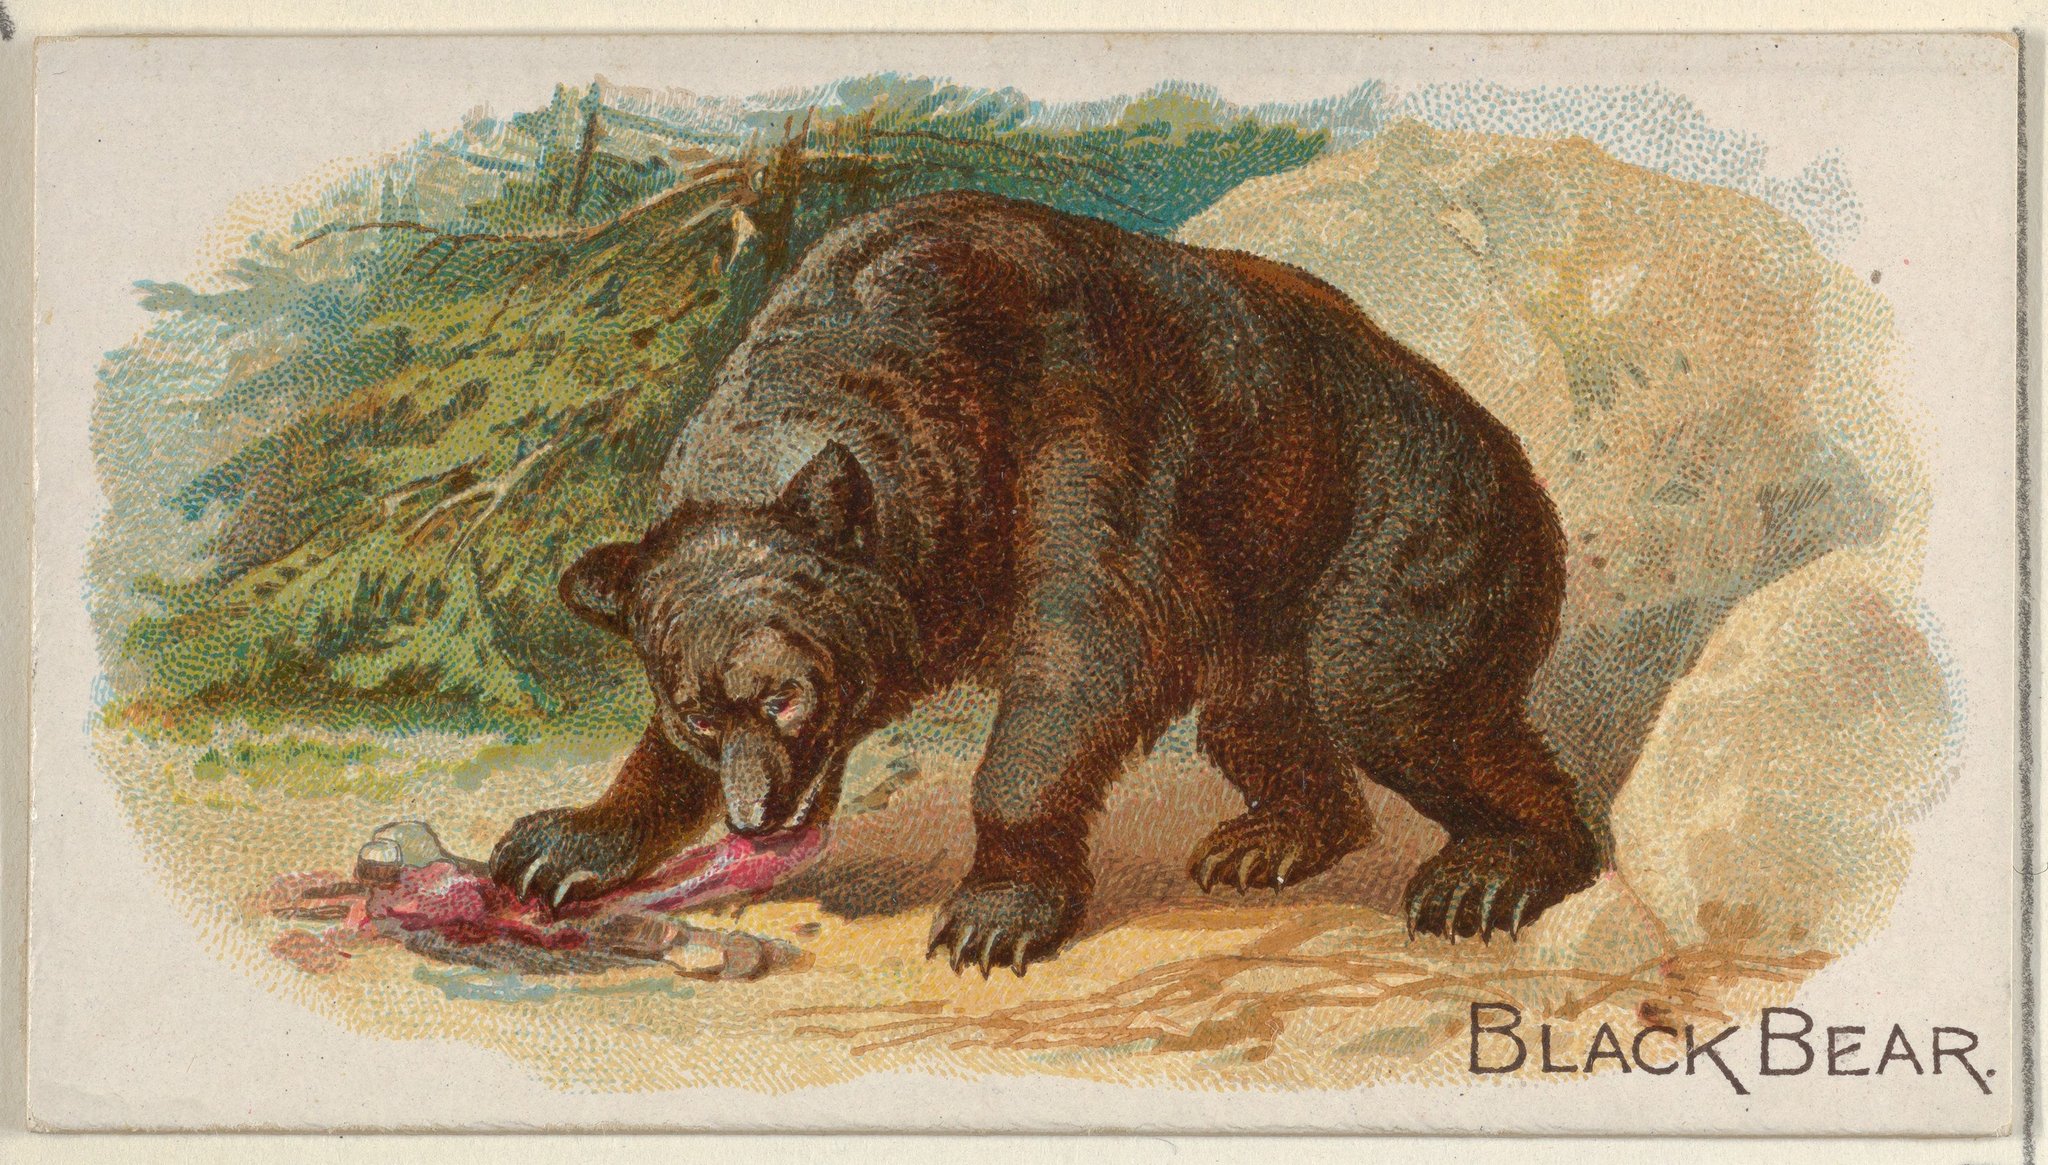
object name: print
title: Black Bear, from the Quadrupeds series (N21) for Allen & Ginter Cigarettes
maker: allen & ginter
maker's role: publisher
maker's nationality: american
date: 1890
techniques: color lithograph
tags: bears